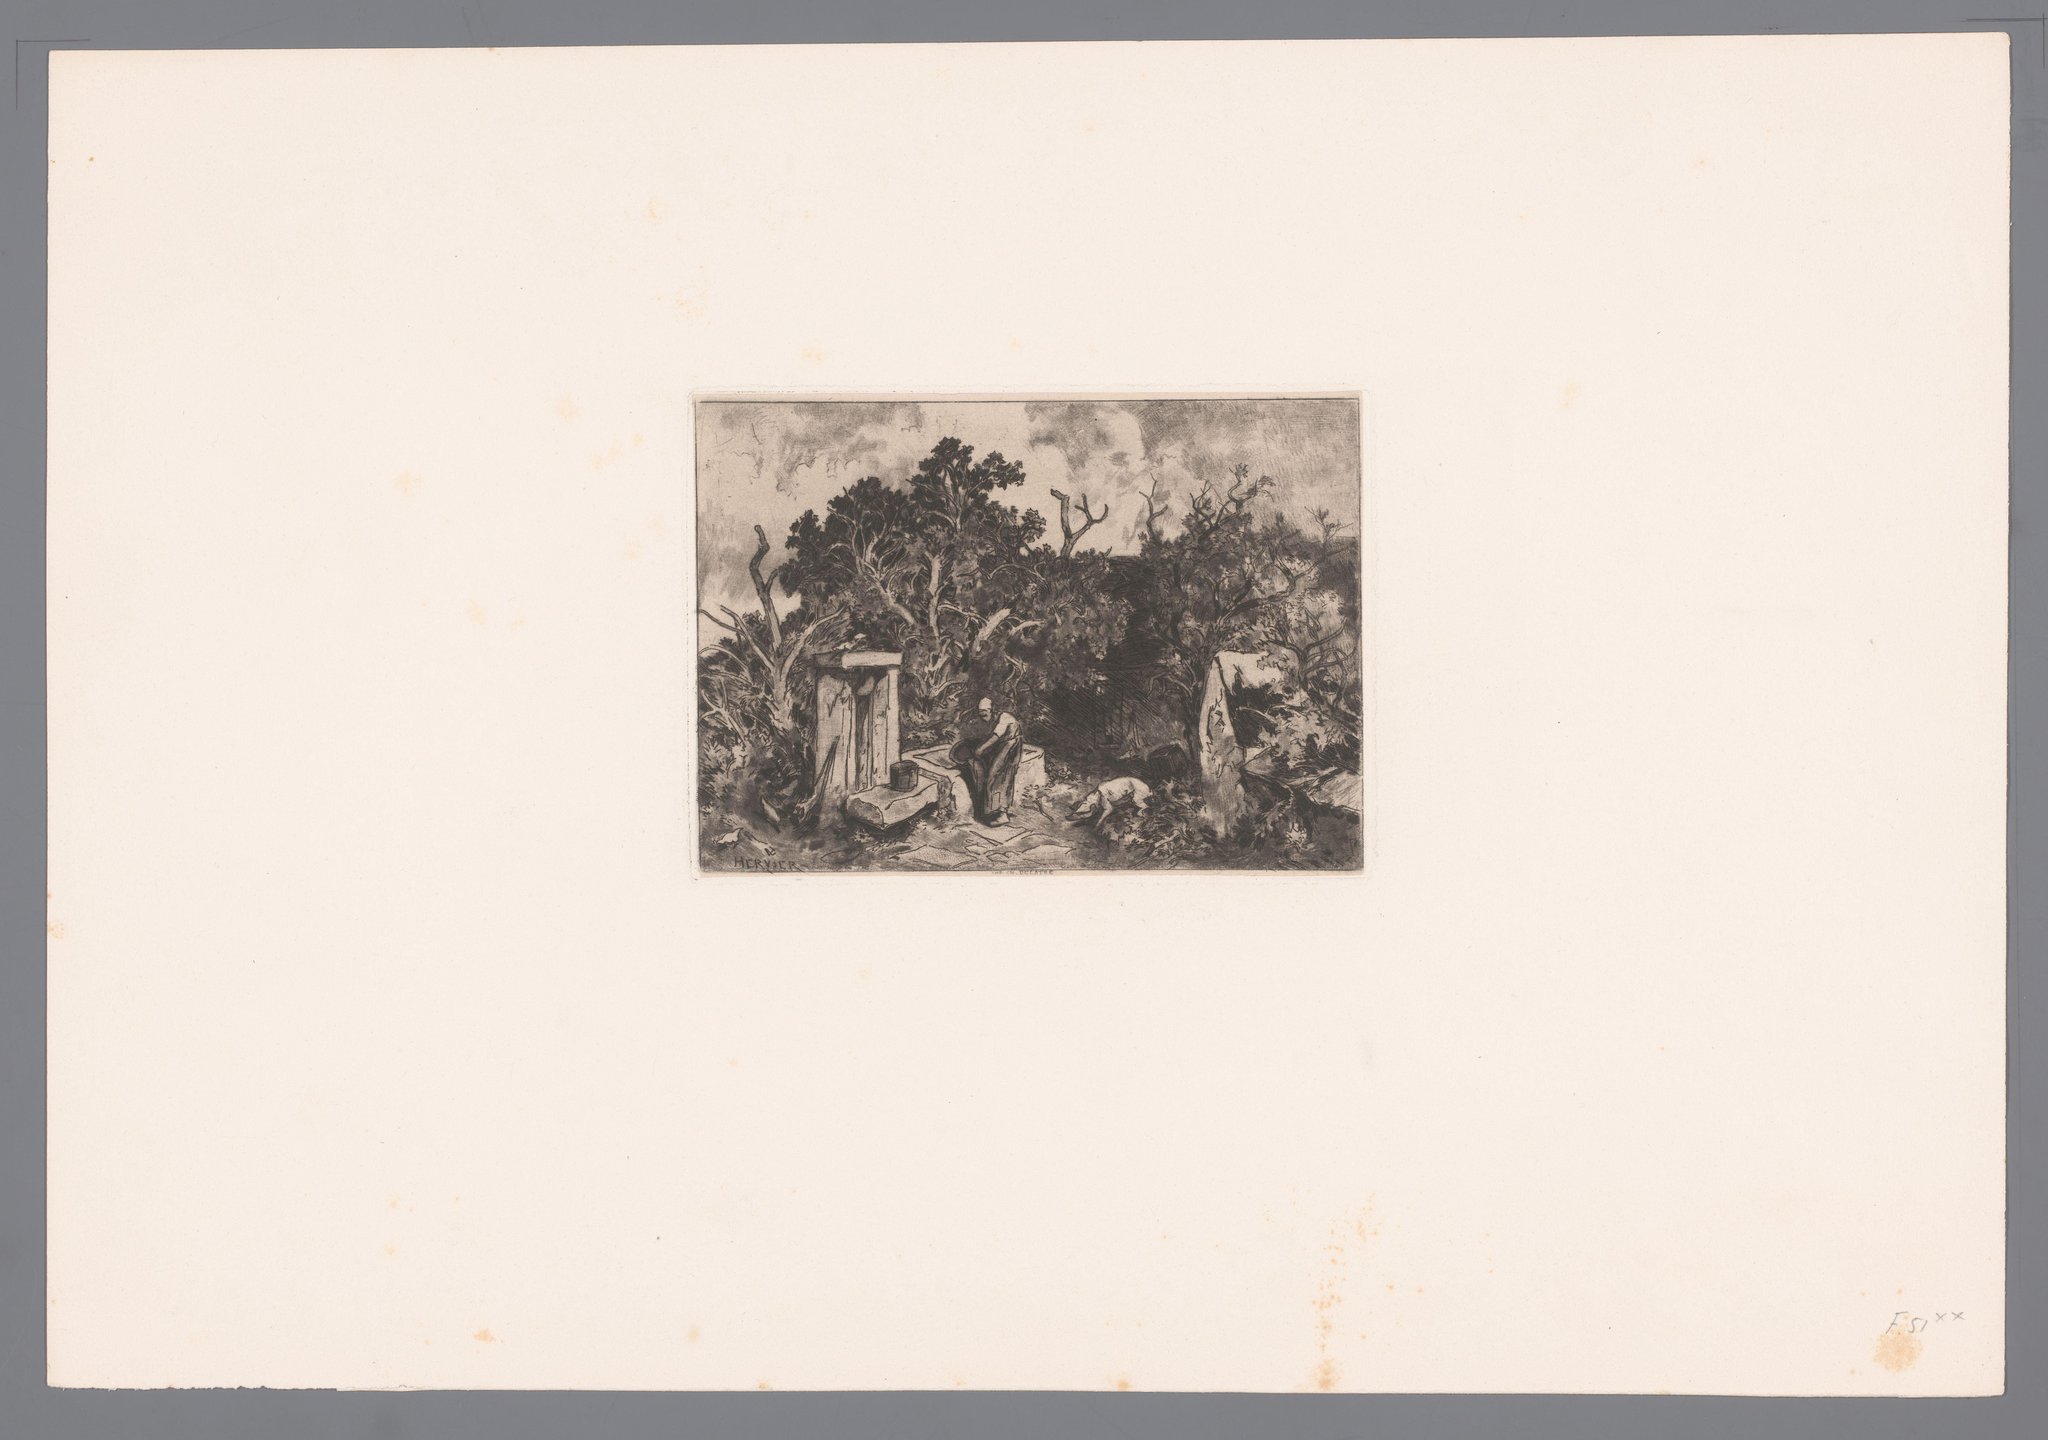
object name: print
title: Collectie prenten door Hervier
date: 1875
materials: paper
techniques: etching, roulette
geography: paris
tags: trough, well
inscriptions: collector's mark: Lugt 2166, collector's mark: Lugt 2760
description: De prent bevindt zich in een omslag en maakt deel uit van een zesdelige serie prenten met verschillende onderwerpen, samengesteld en uitgevoerd door Hervier.